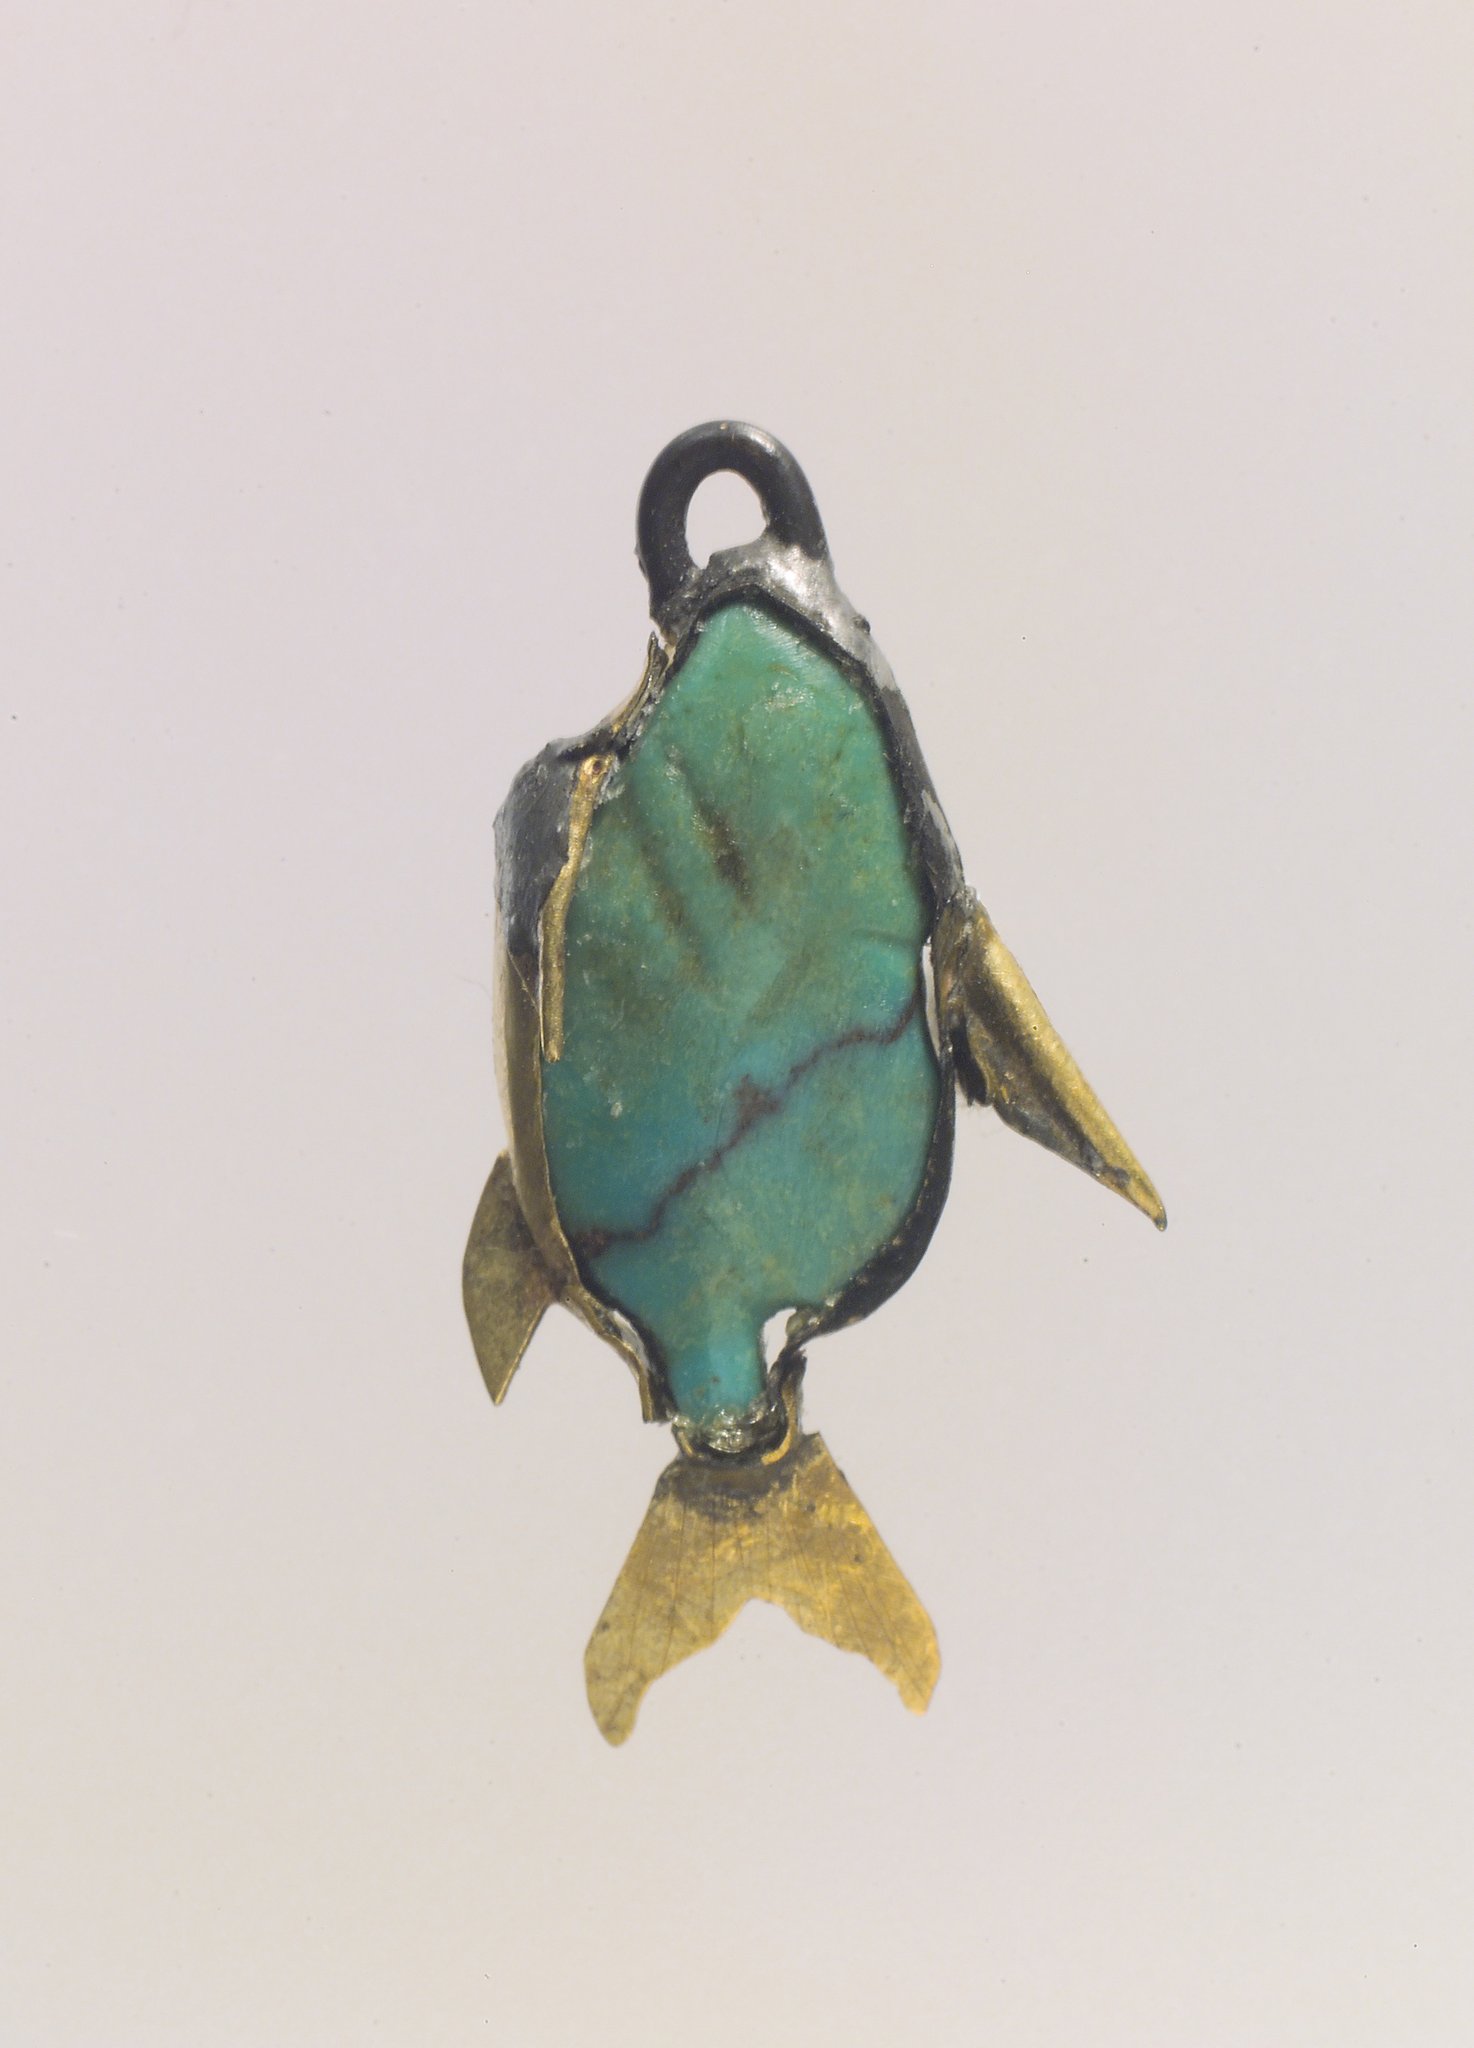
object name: amulet, fish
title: Fish Pendant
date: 1878-1749 BCE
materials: gold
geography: egypt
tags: fish